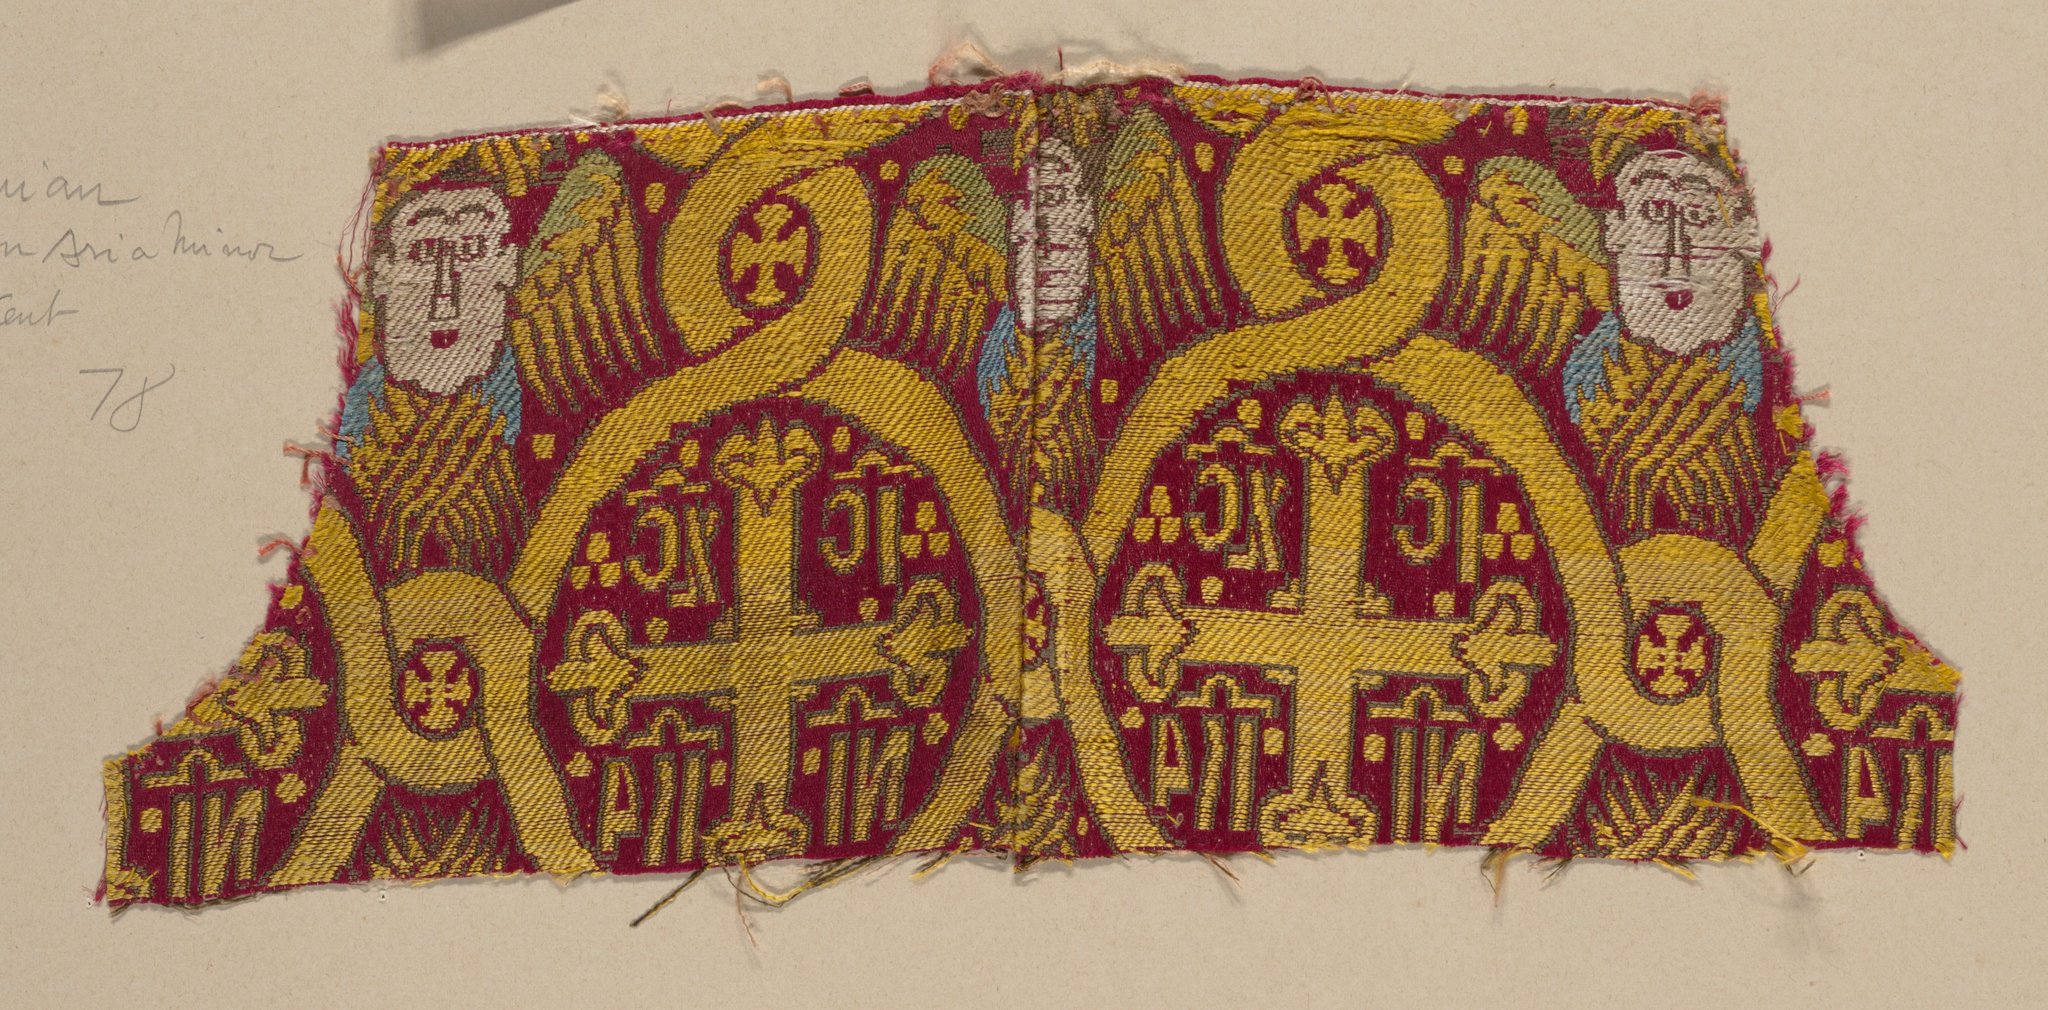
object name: fragment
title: Fragment of woven silk with Seraphim and Crosses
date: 1601-1700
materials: silk